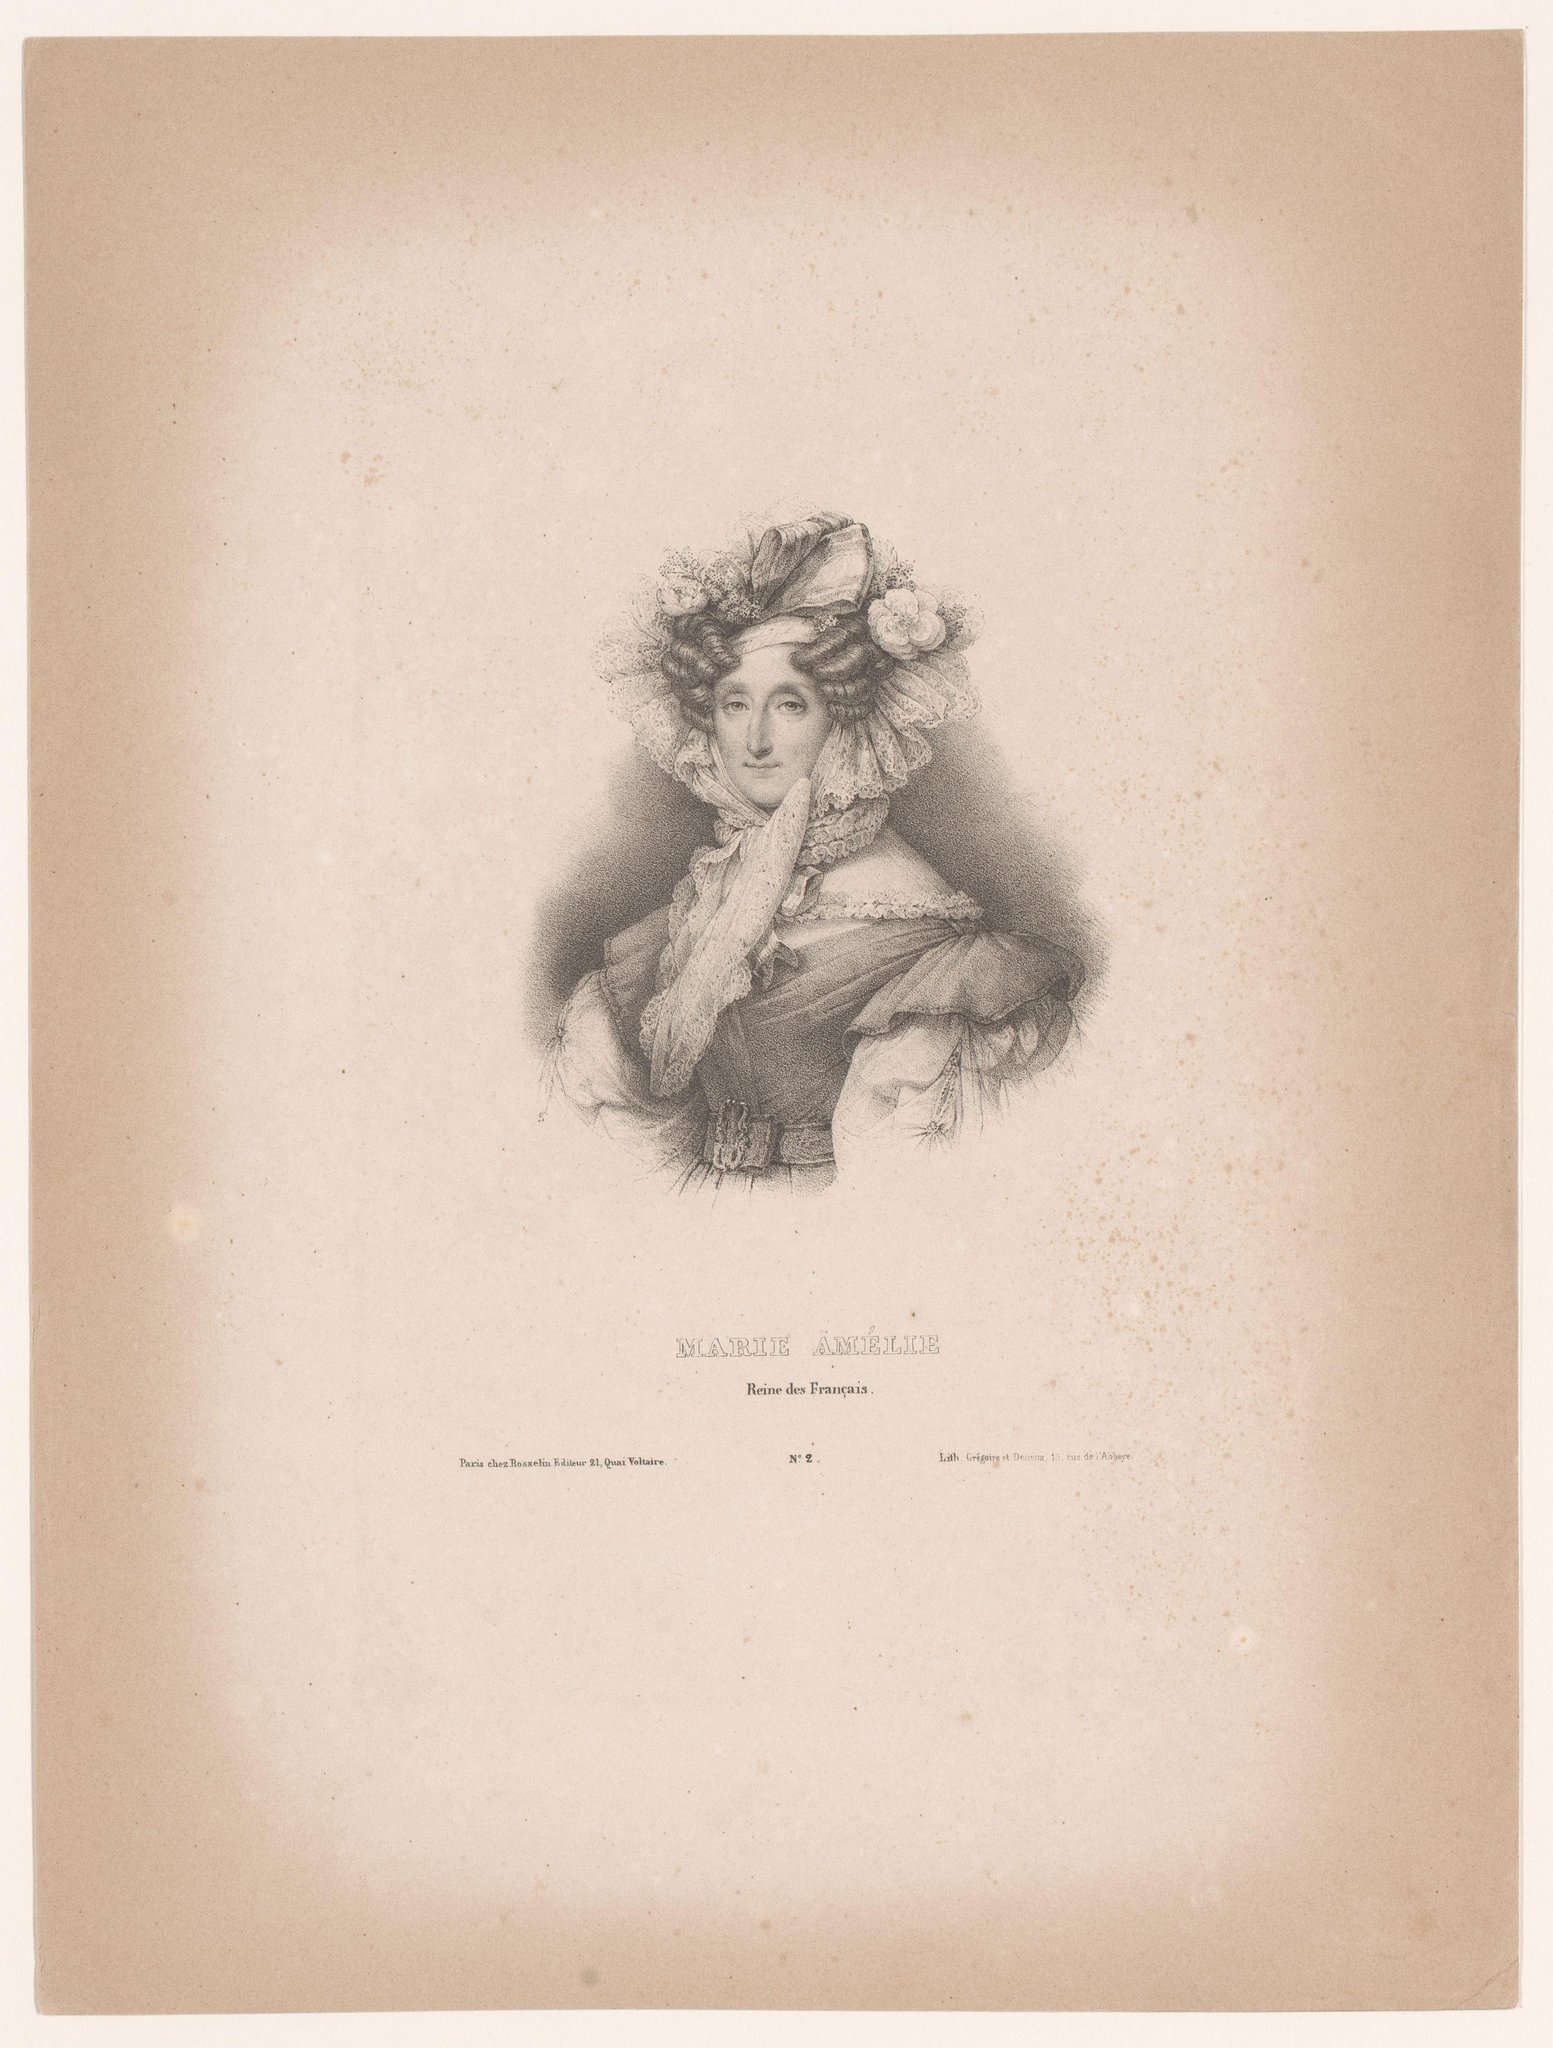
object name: print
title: Marie Amélie, reine des Français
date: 1844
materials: paper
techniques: lithograph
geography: paris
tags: london, historical persons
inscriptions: collector's mark: Lugt 2228a